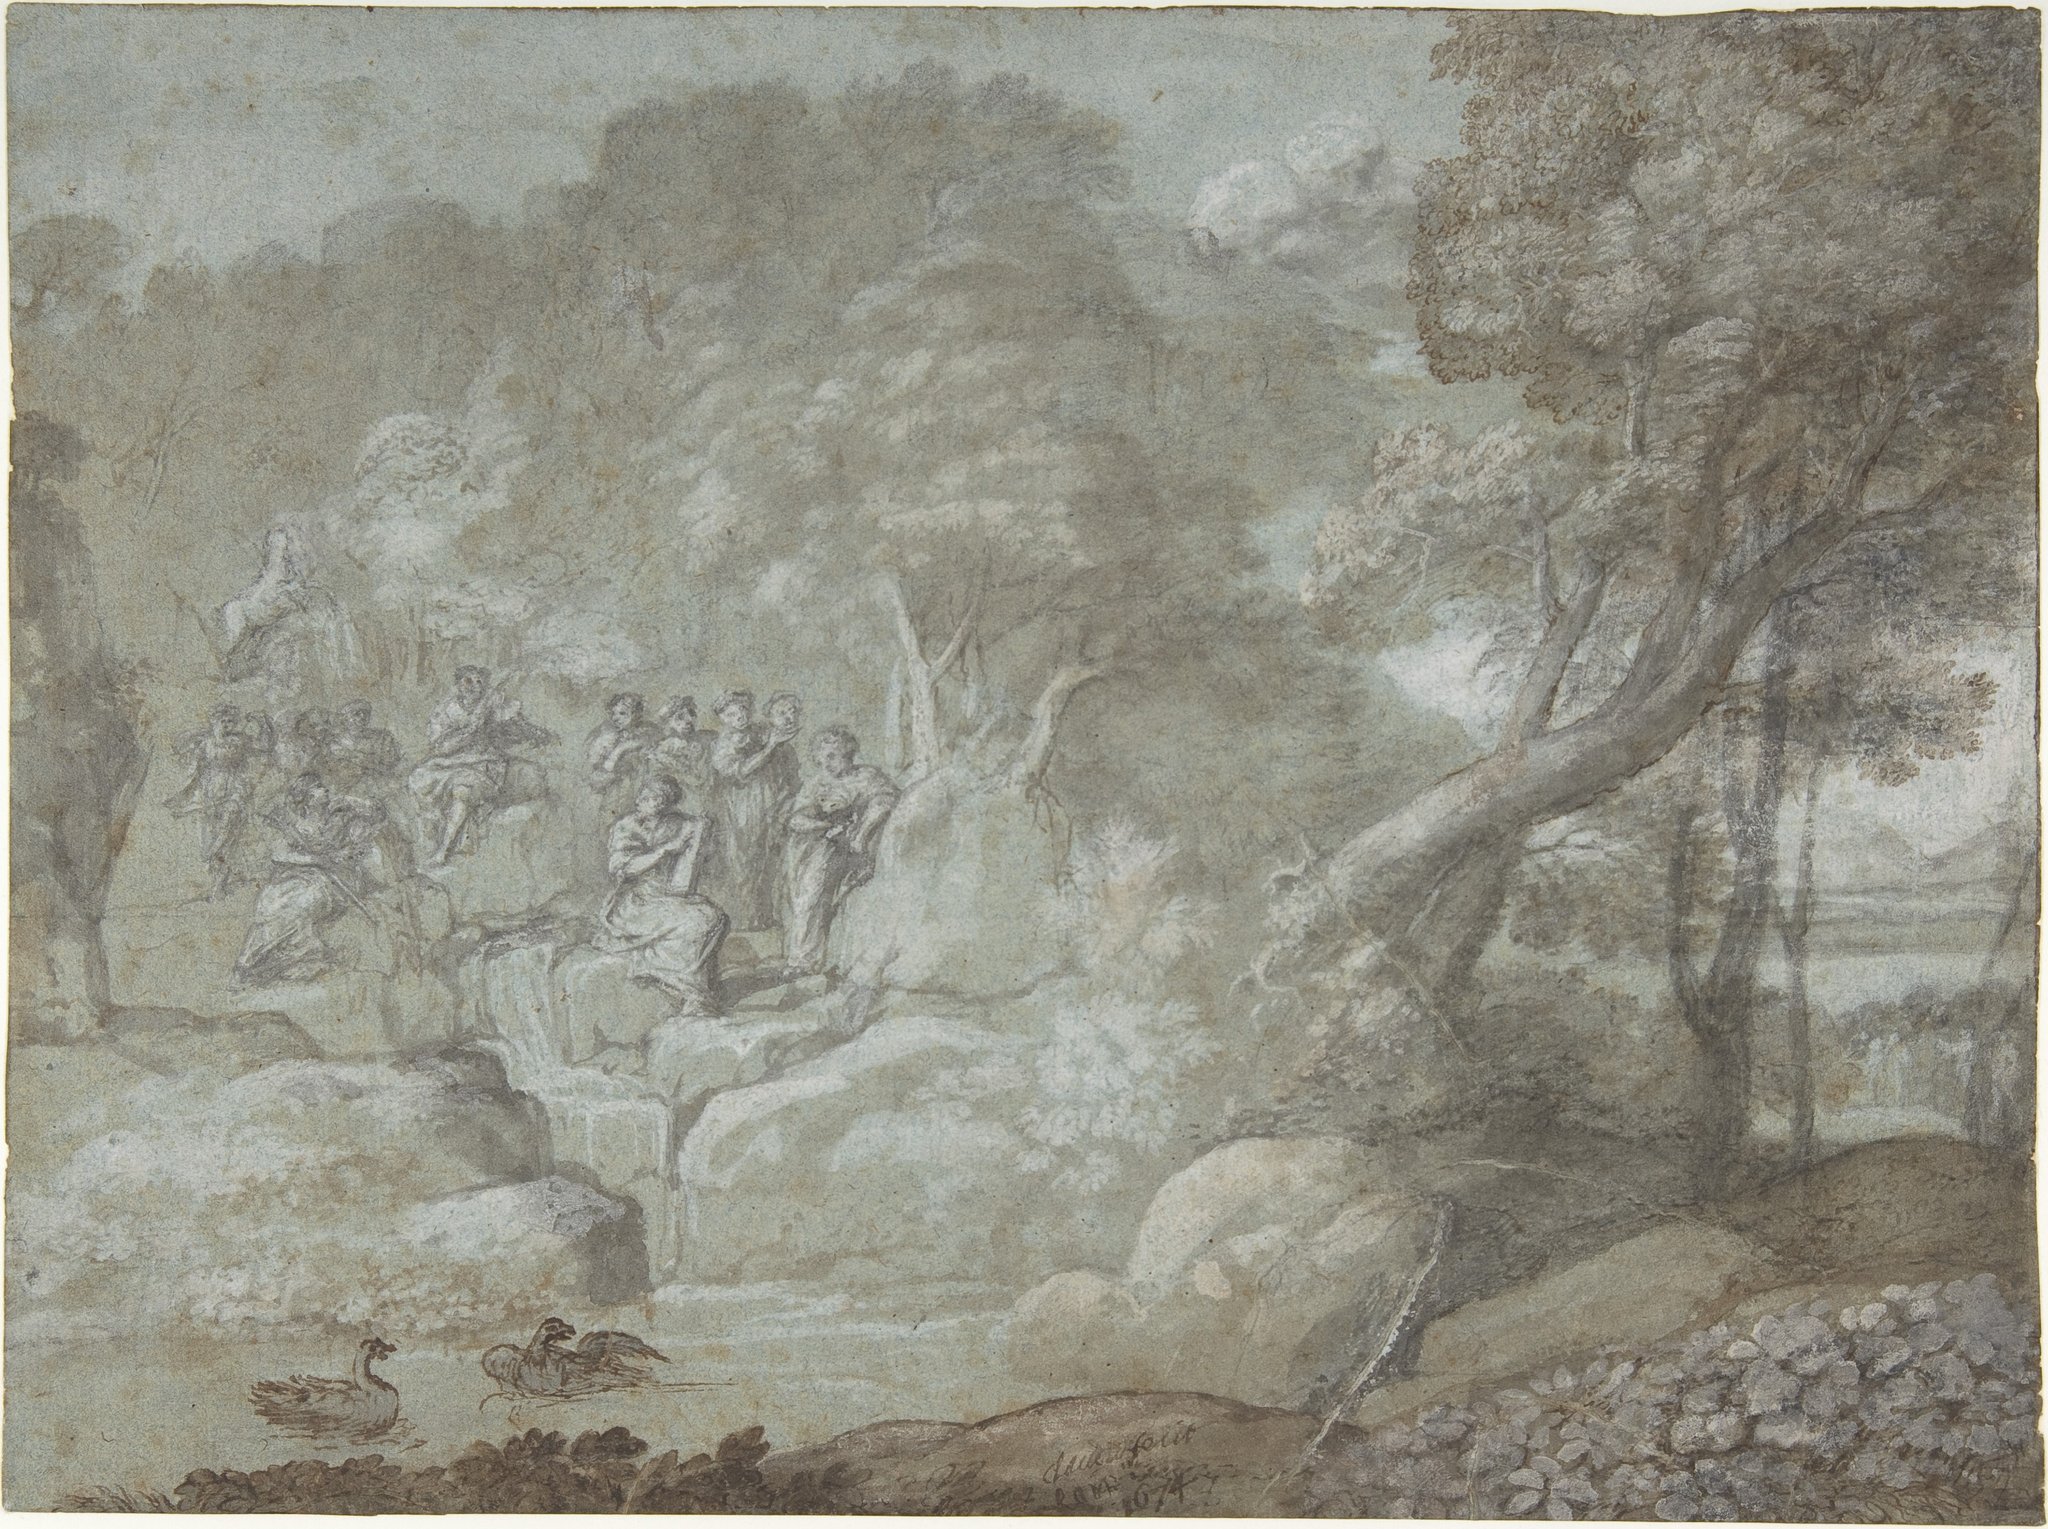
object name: drawing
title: Landscape with Apollo and the Muses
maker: claude lorrain (claude gellée)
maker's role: artist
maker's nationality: french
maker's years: 1604-1682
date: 1674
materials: gouache, graphite, ink, paper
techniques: brush, pen, wash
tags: birds,apollo,muses,landscapes,trees